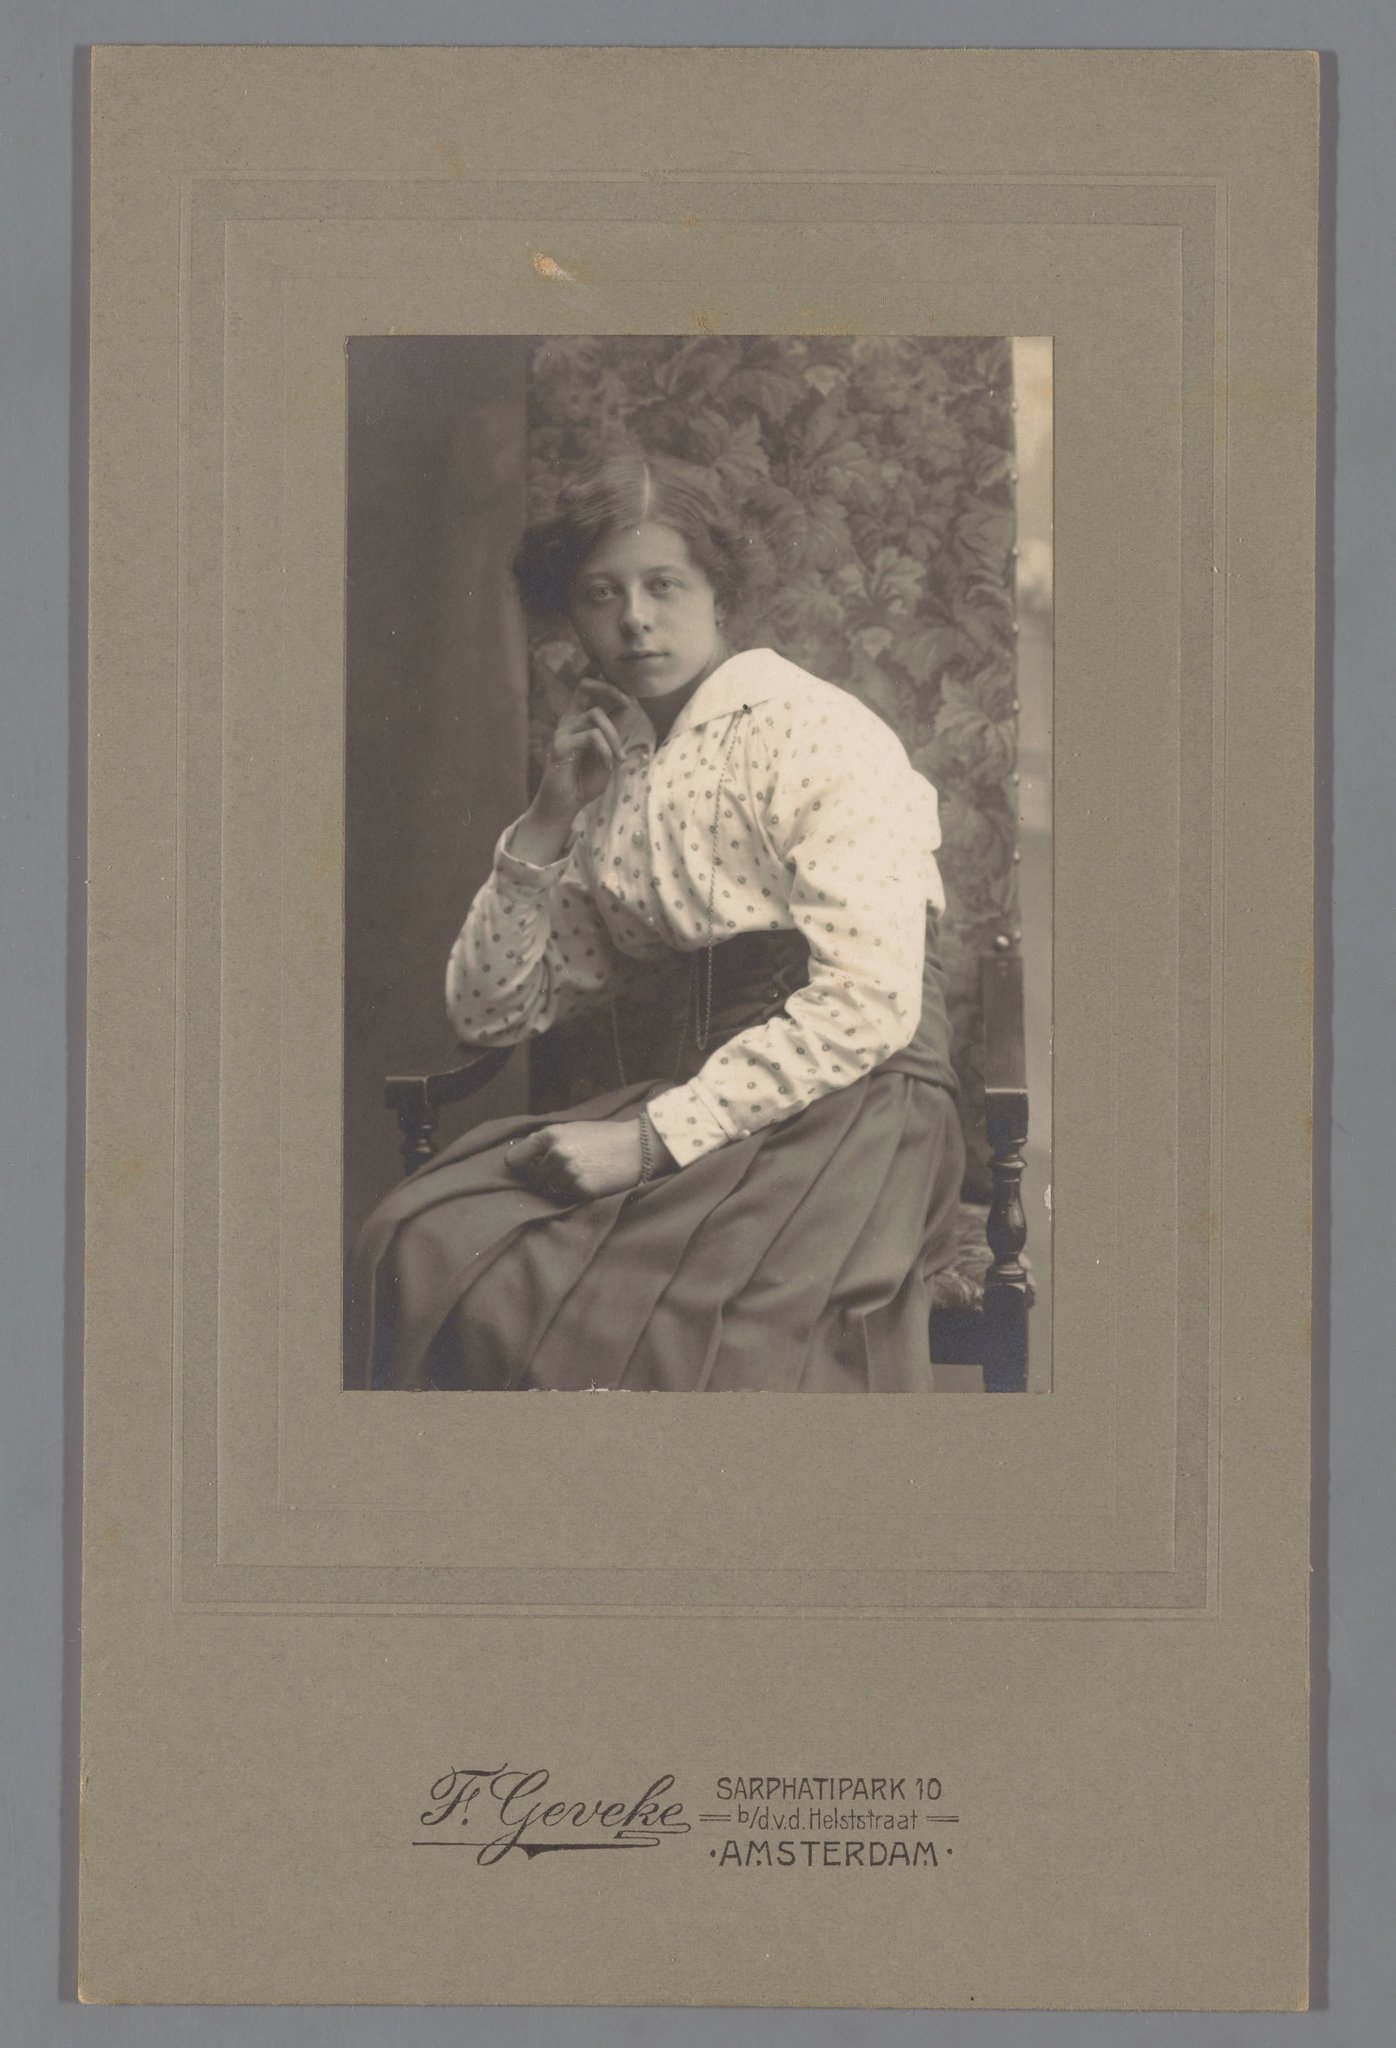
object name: cabinet photograph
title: Portret van een onbekende vrouw op een stoel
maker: frits geveke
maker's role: fotograaf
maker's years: 1878-1950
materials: cardboard, photographic support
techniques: gelatin silver print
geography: amsterdam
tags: adult woman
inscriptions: name: ‘fam a [...]’, name: ‘F. Geveke Sarphatipark 10 b/d v.d. Helststraat Amsterdam.’